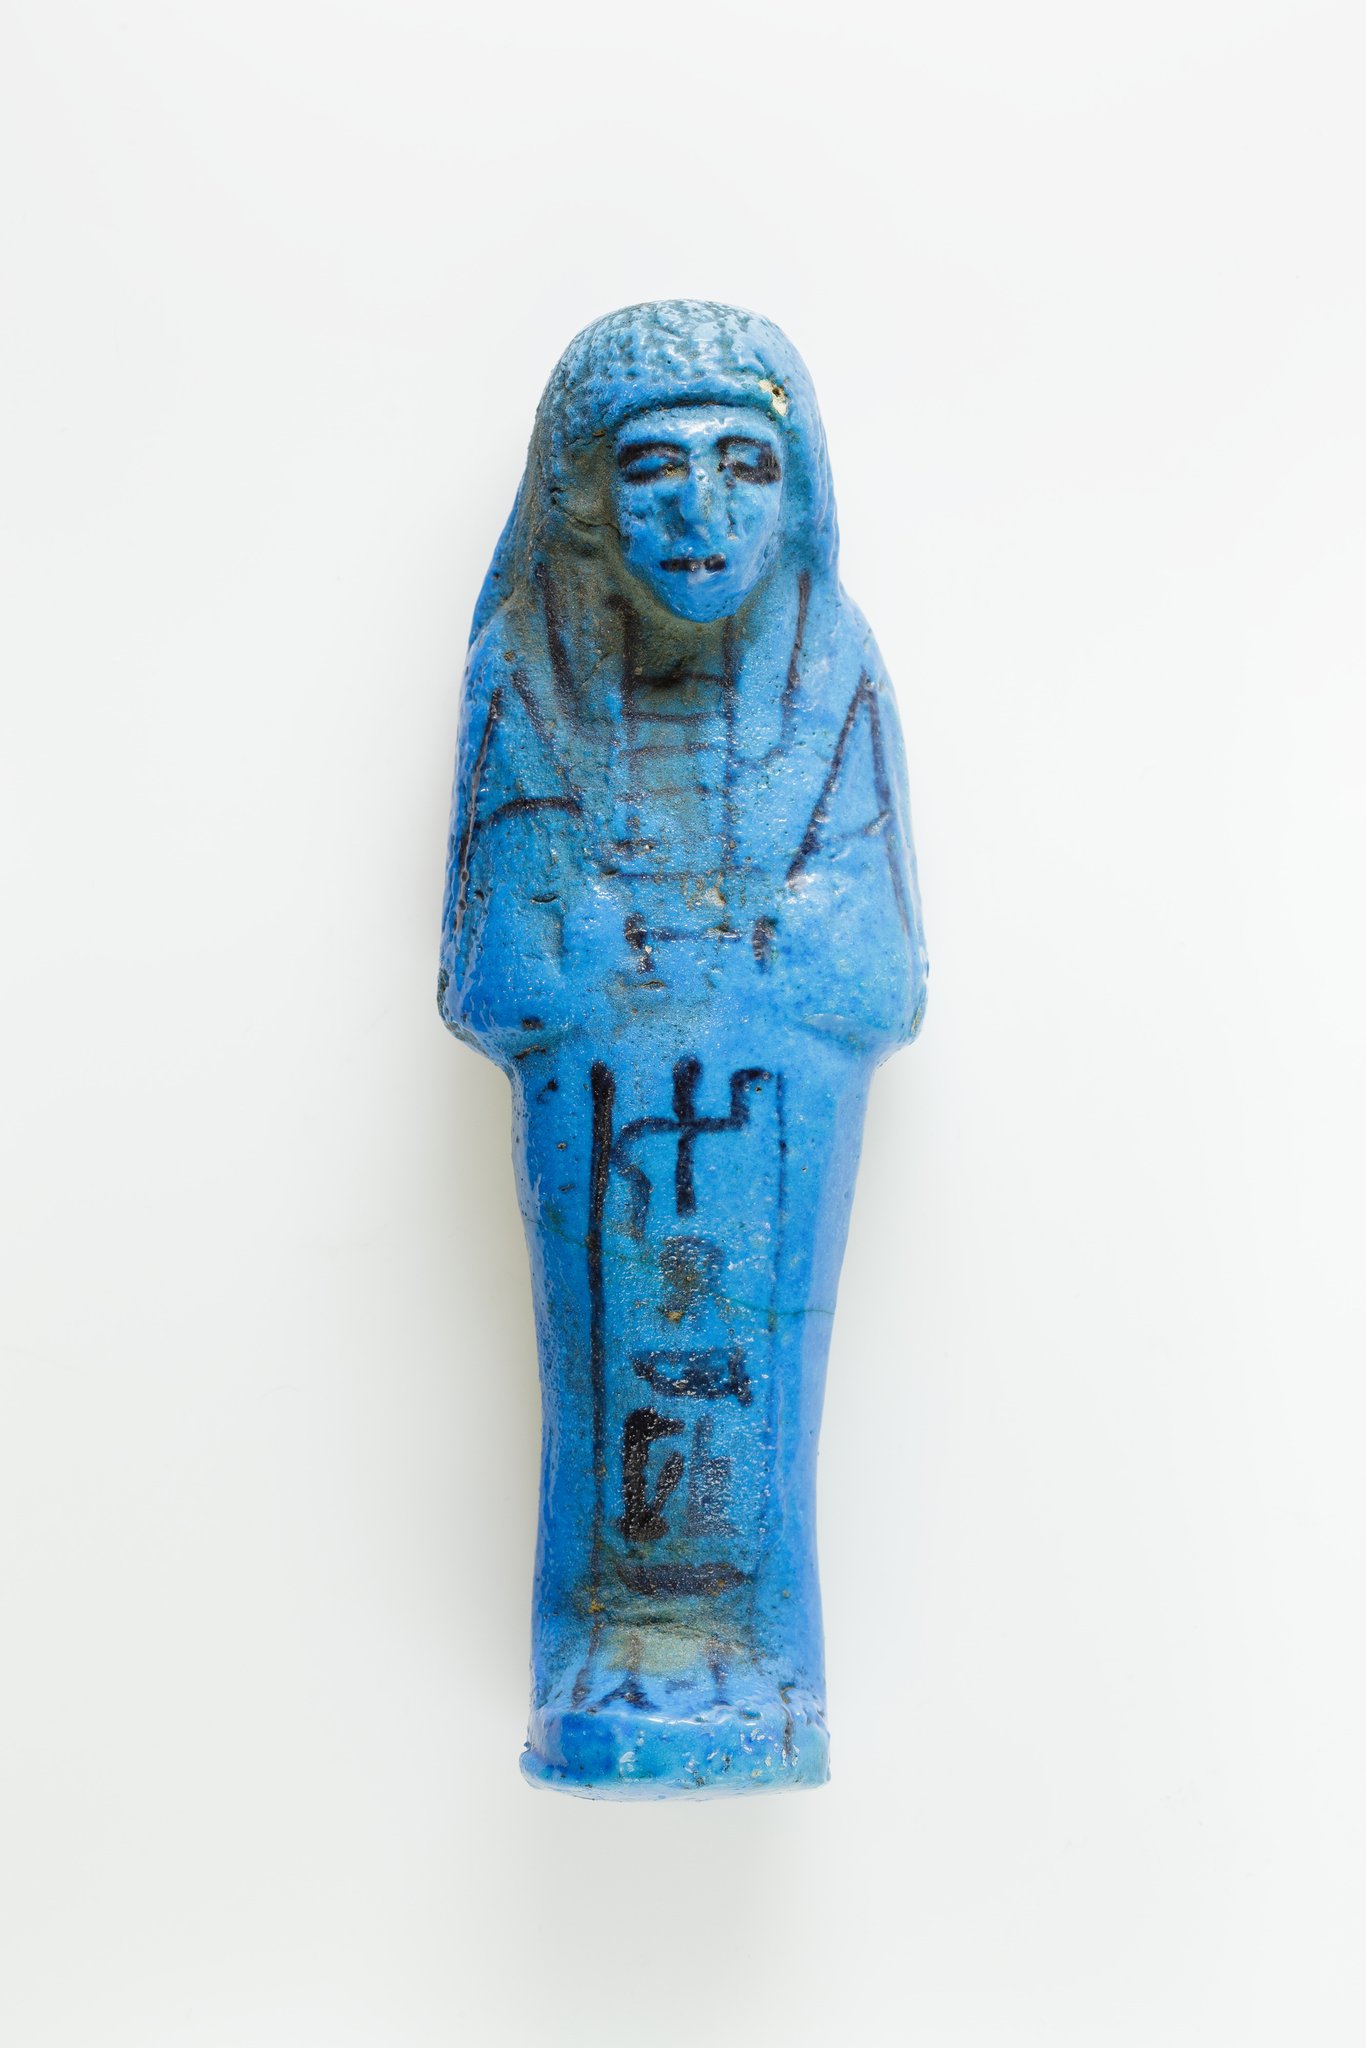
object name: shabti of nebneheh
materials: faience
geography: egypt